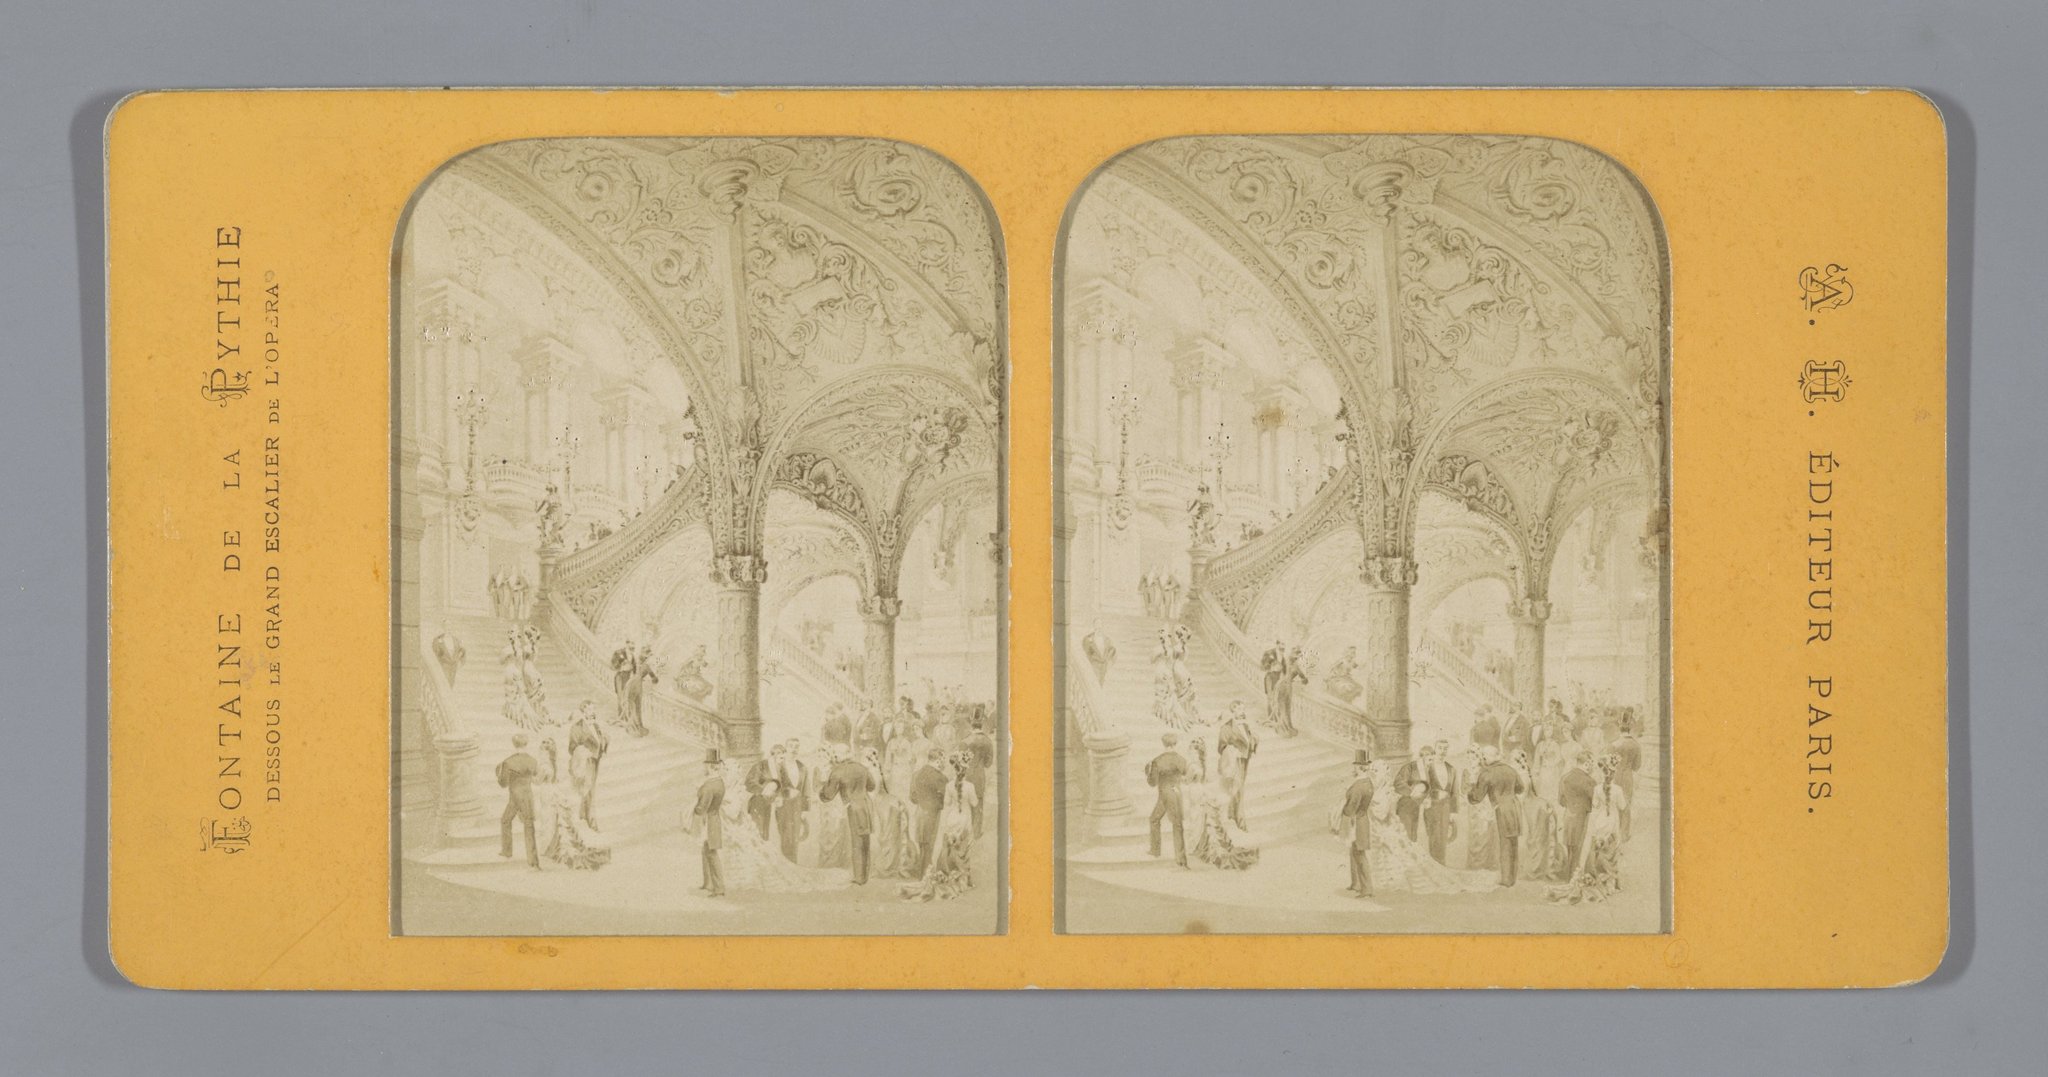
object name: reproduction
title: Fotoreproductie van een ontwerp van de fontein van de Pythia, onder de trap van de Opéra Garnier, Parijs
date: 1875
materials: cardboard, paper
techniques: albumen print, hand coloring, perforating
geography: paris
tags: foyer ~ theatre, etc., opera house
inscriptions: number: ‘2/ No 23’